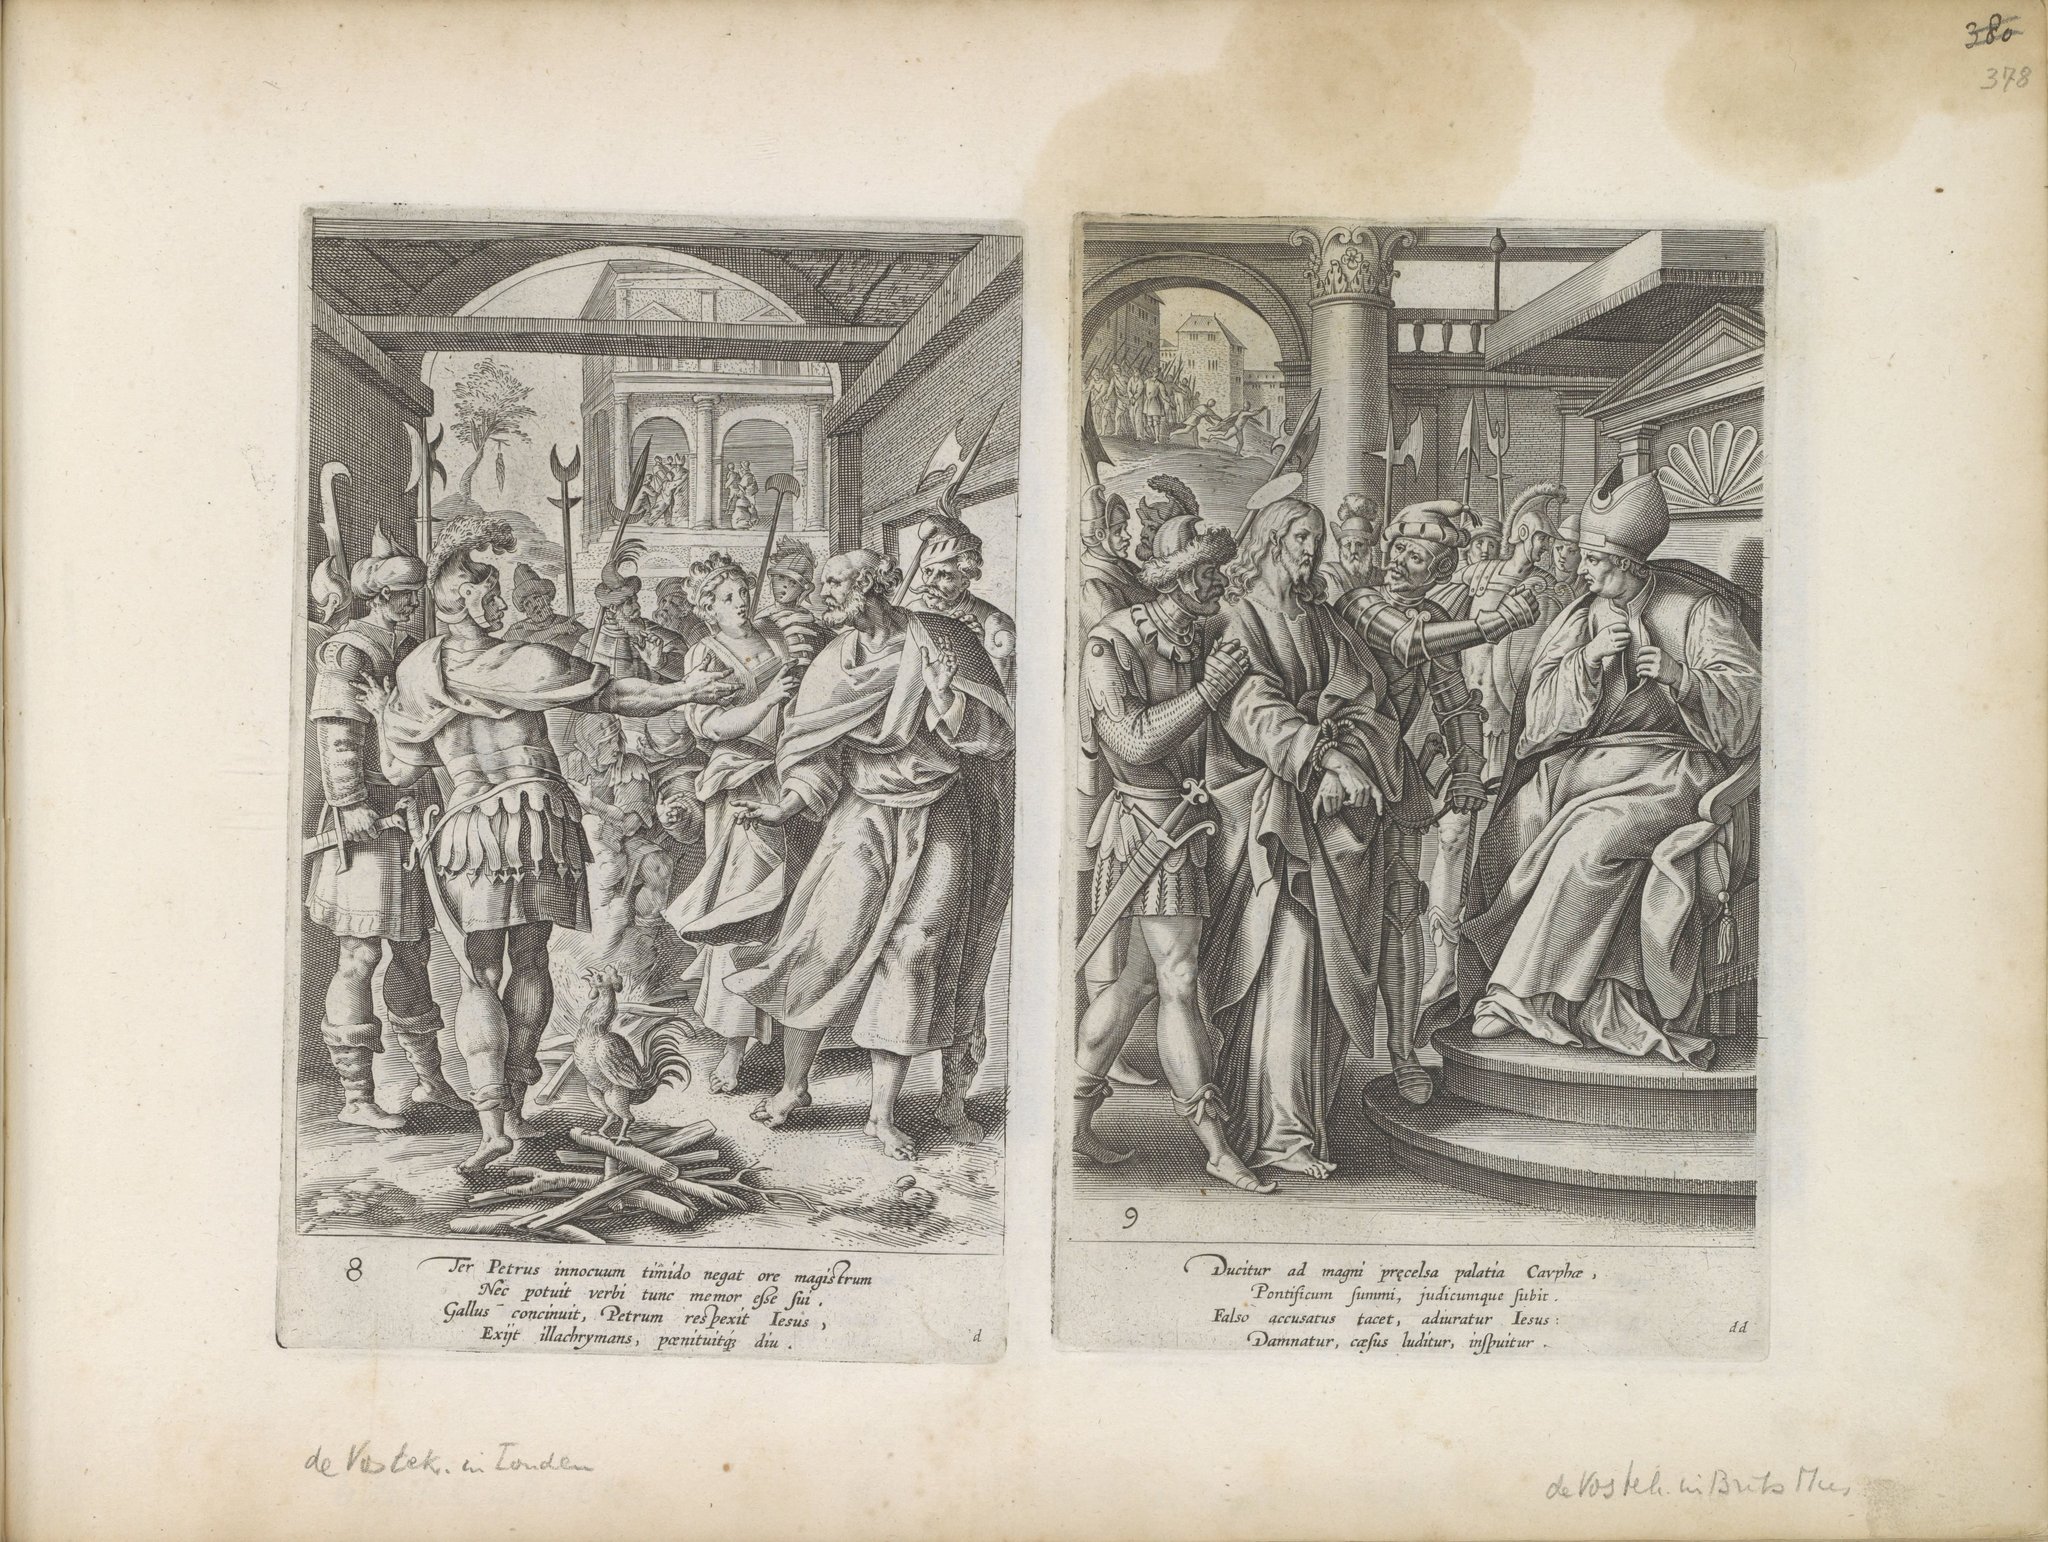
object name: album leaf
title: Christus voor Kajafas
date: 1585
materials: paper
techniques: engraving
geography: amsterdam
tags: caiaphas tearing his clothes ~ trial of christ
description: Soldaten leiden Christus voor Kajafas. De hogepriester scheurt zijn gewaad en beschuldigt Christus van godslastering. Onder de voorstelling een vierregelig vers in het Latijn. Rechtsonder de letters: dd. Deze prent maakt deel uit van een album.